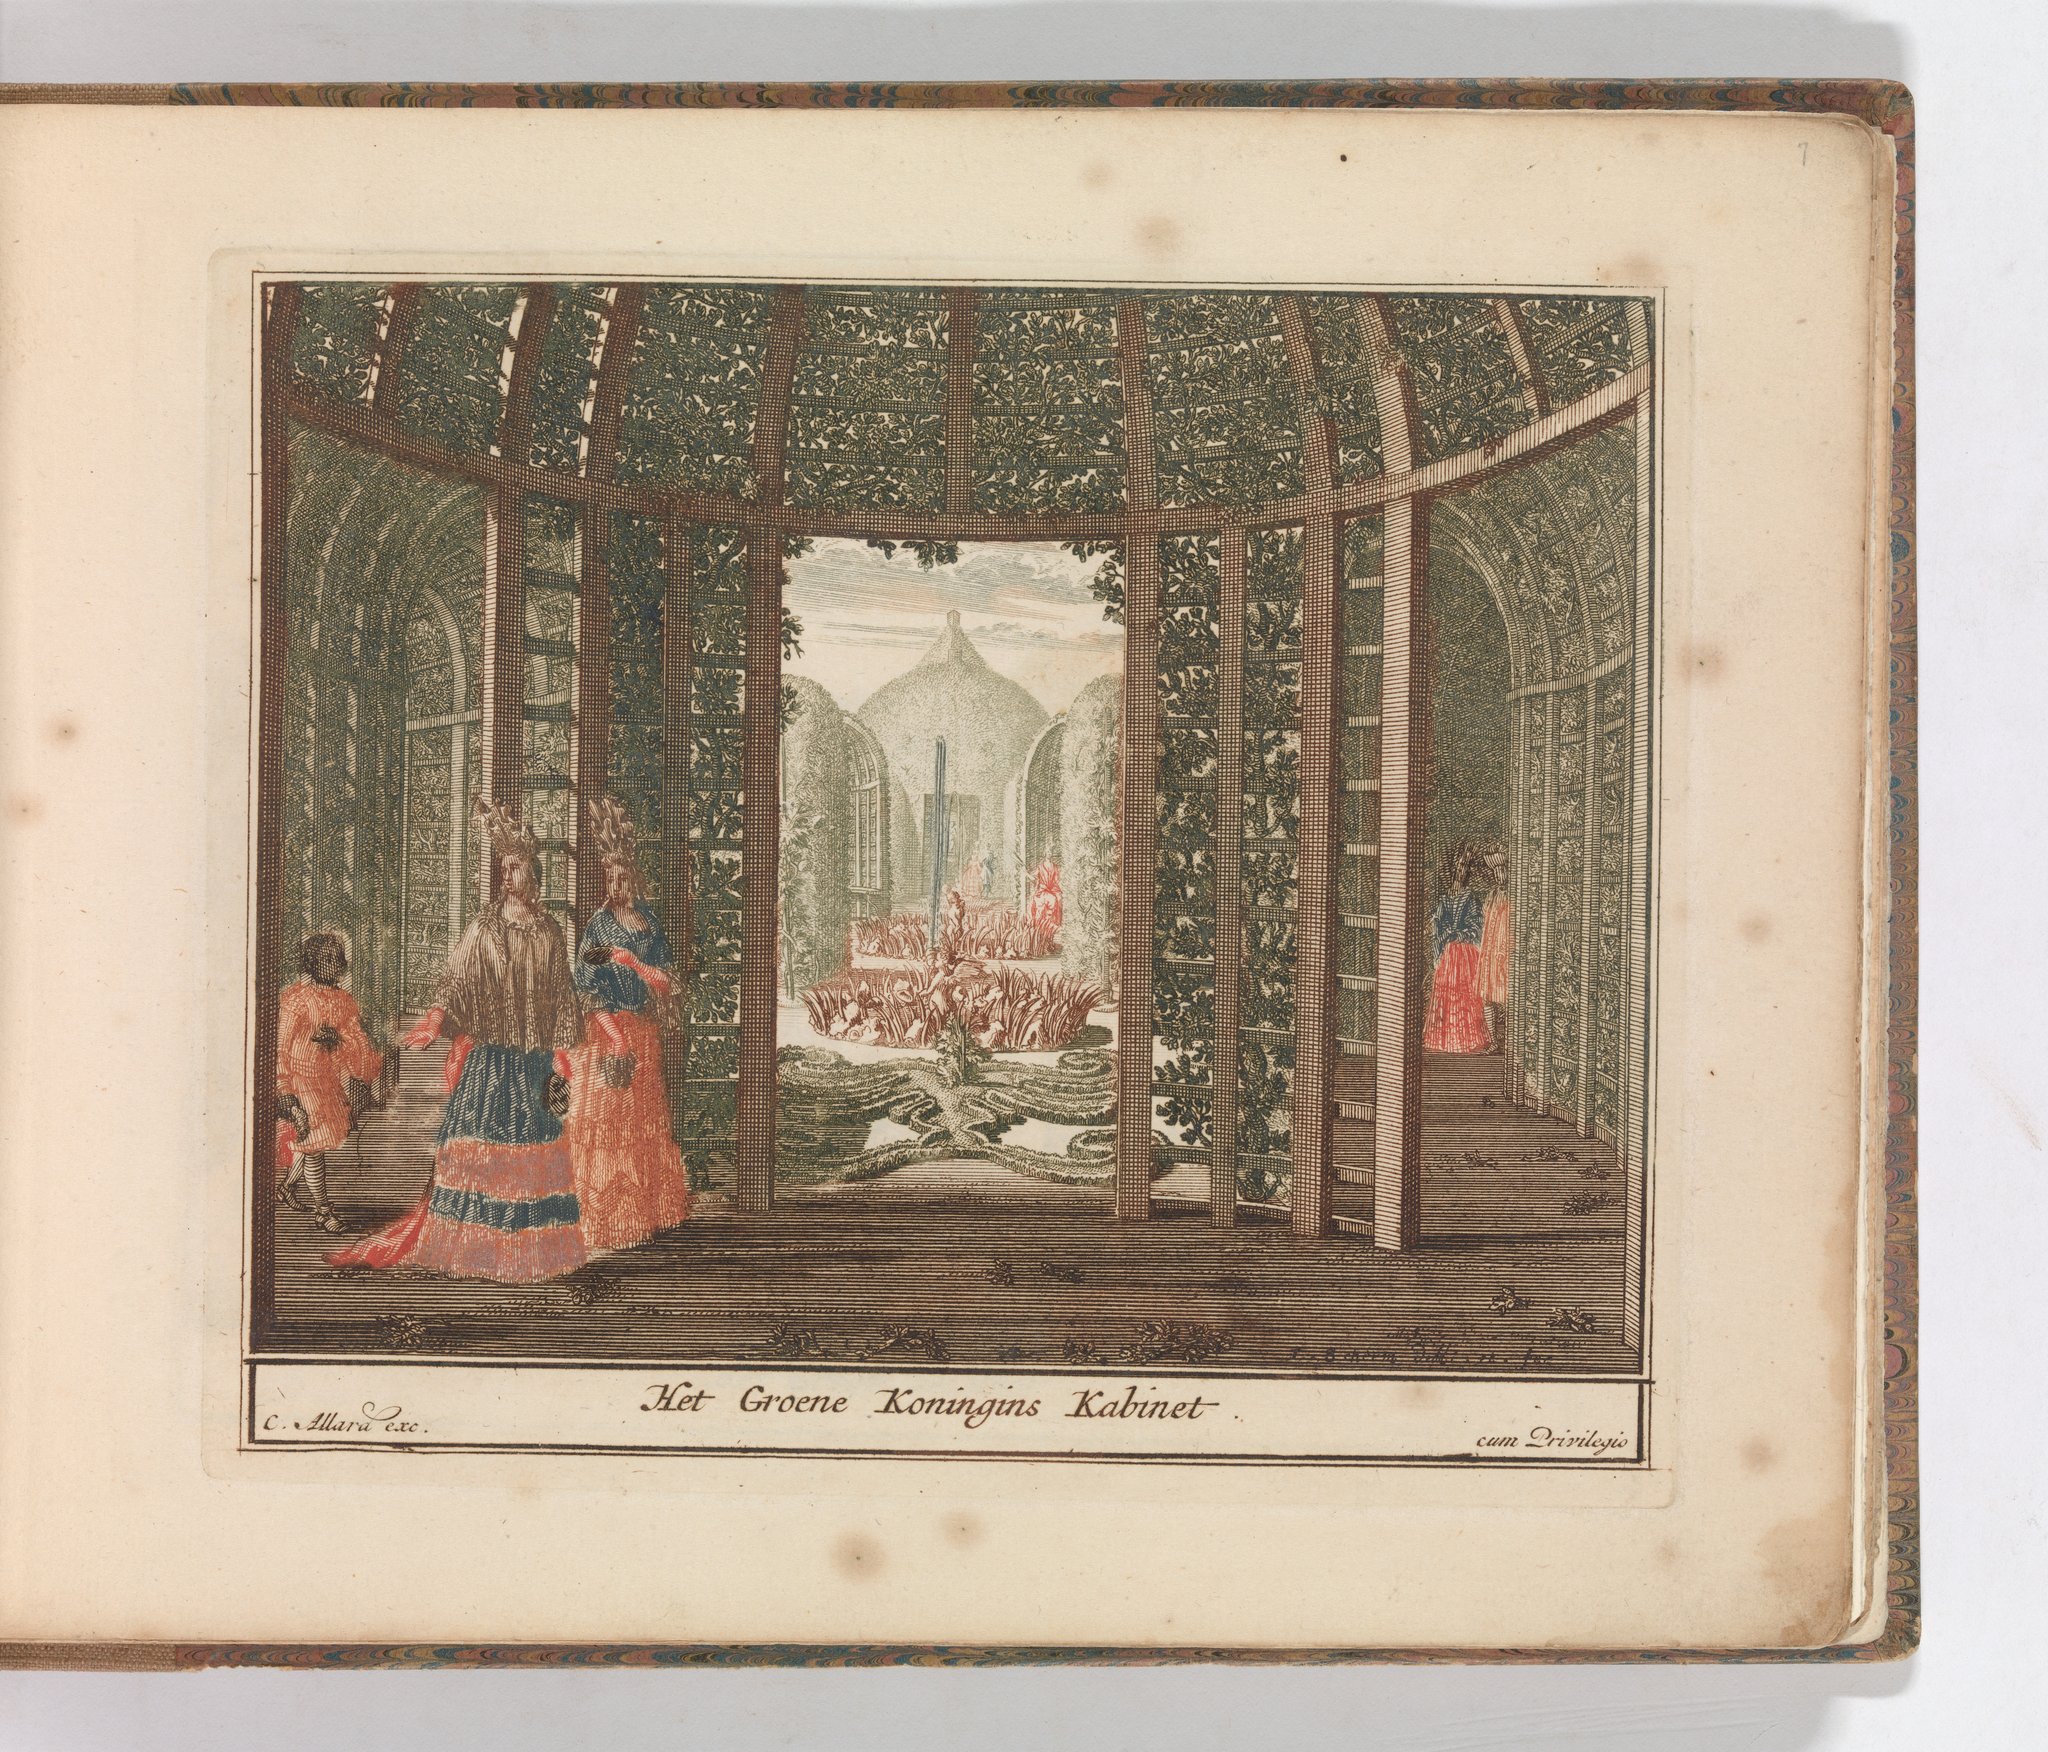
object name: book print ornament architecture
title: 'Het Groene Koningins Kabinet', in: Tooneel Der Voornaamste Nederlands Huizen, En Lust Hoven, Naar T Leven Afgebeeld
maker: carel allard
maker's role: publisher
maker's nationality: dutch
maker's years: 1648-1709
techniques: engraving, lithography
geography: amsterdam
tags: palaces,queens